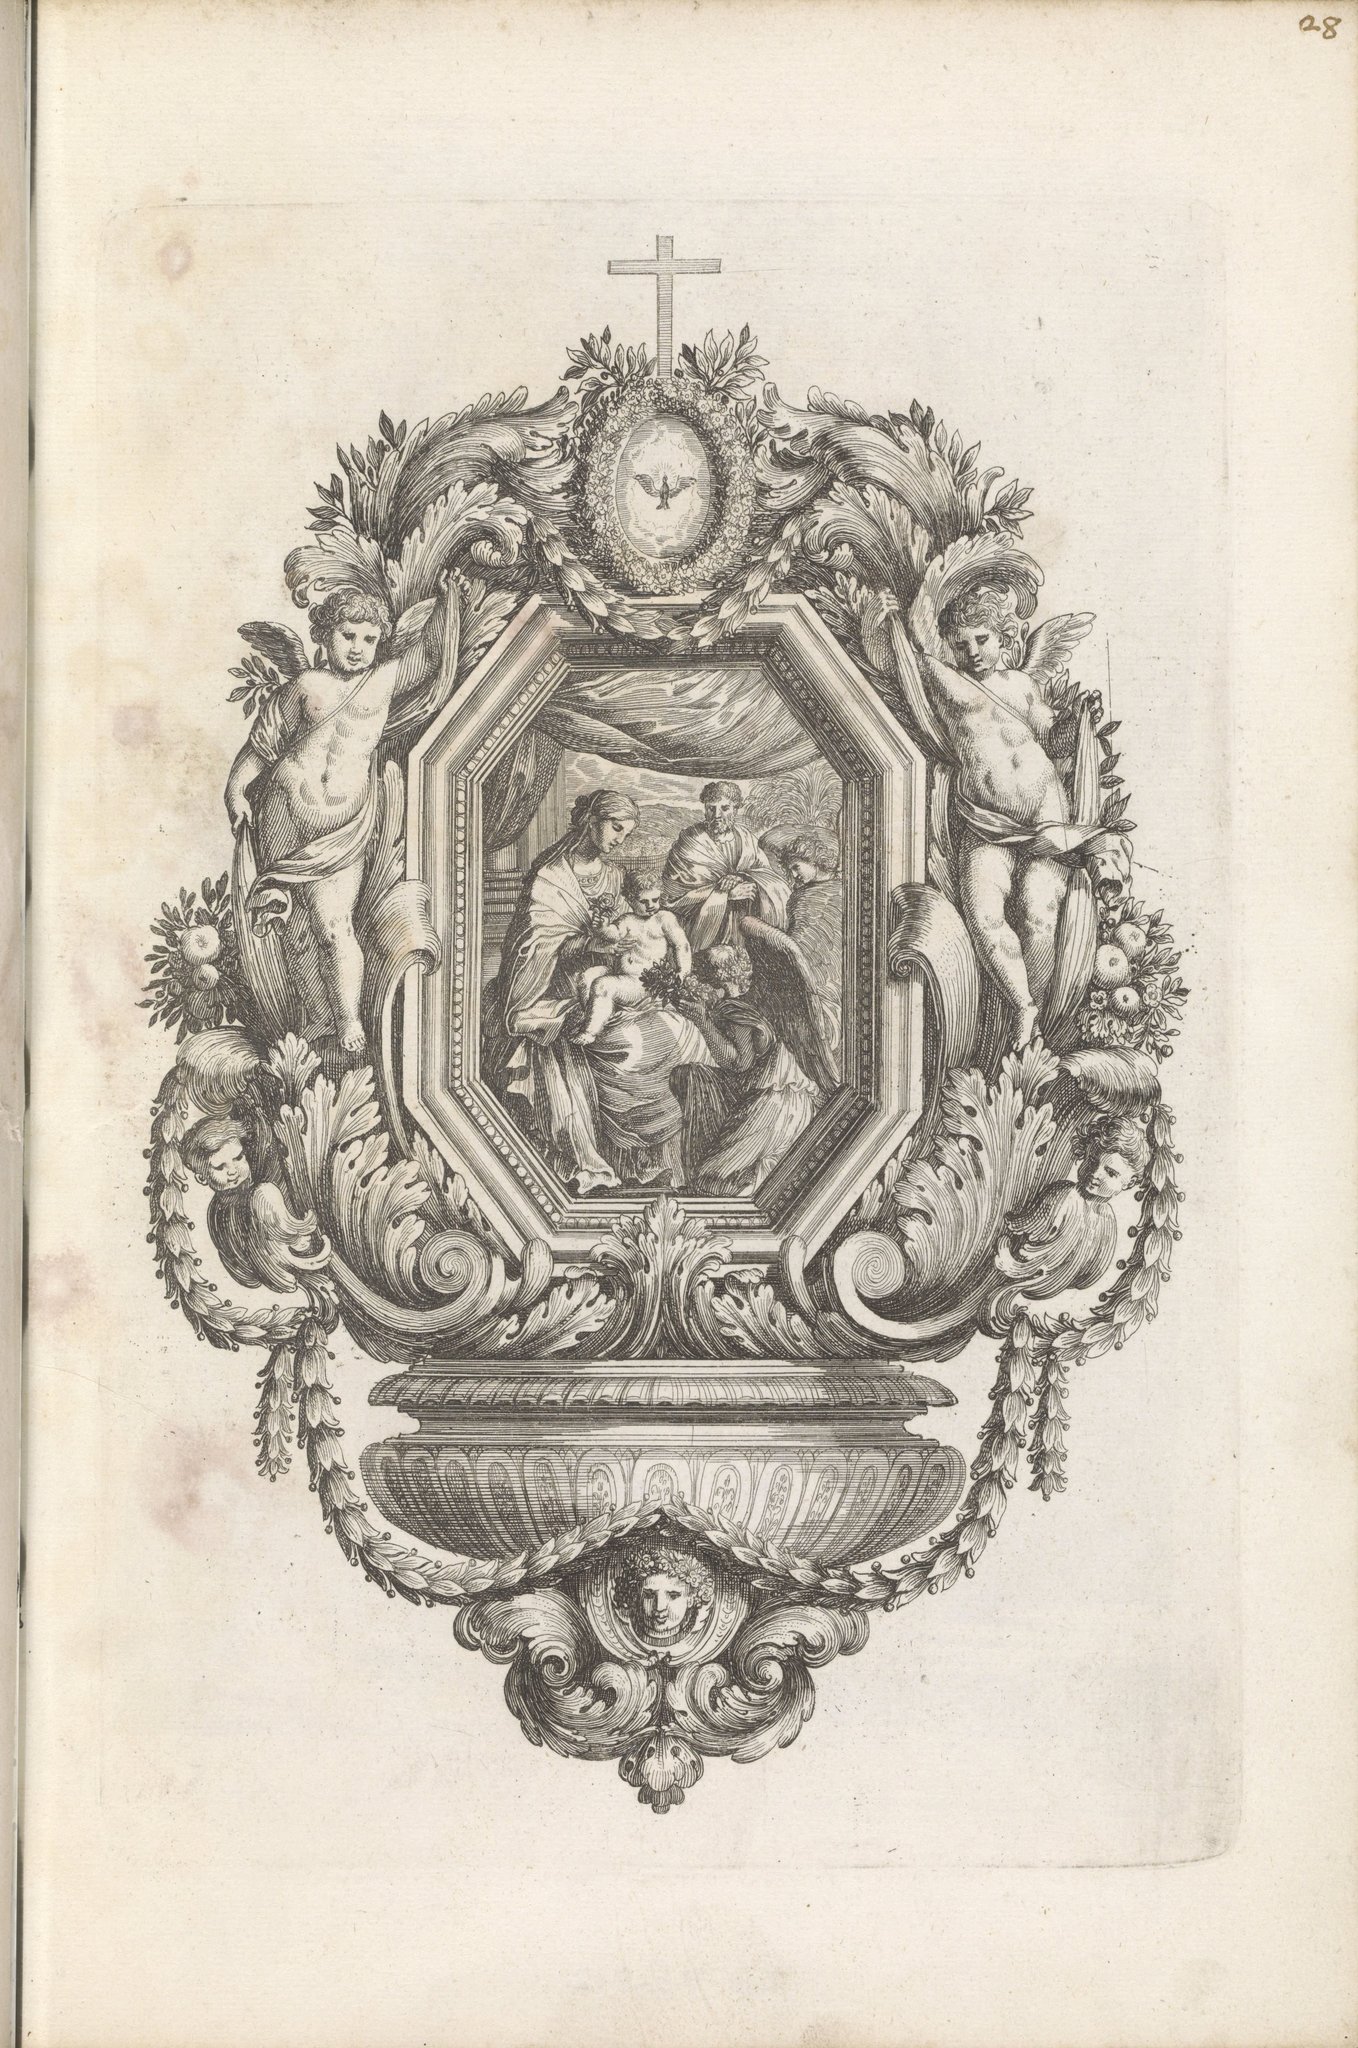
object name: print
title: Wijwaterbak met de Heilige Familie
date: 1677-1692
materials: paper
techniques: etching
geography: paris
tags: ornaments ~ art, holy family, and derived representations, holy water font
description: Wijwaterbak met op de achterplaat Maria met het Christuskind op schoot. Bij hen staat Jozef. Engelen bieden bloemen aan. Uit serie van 6 bladen met kopieën naar de serie Inuentions pour faire des plaques ou des Aubenistiers seruans aux Orfeures van Jean Lepautre. Ontwerpen voor wijwaterbakken. Prent maakt deel uit van een album.